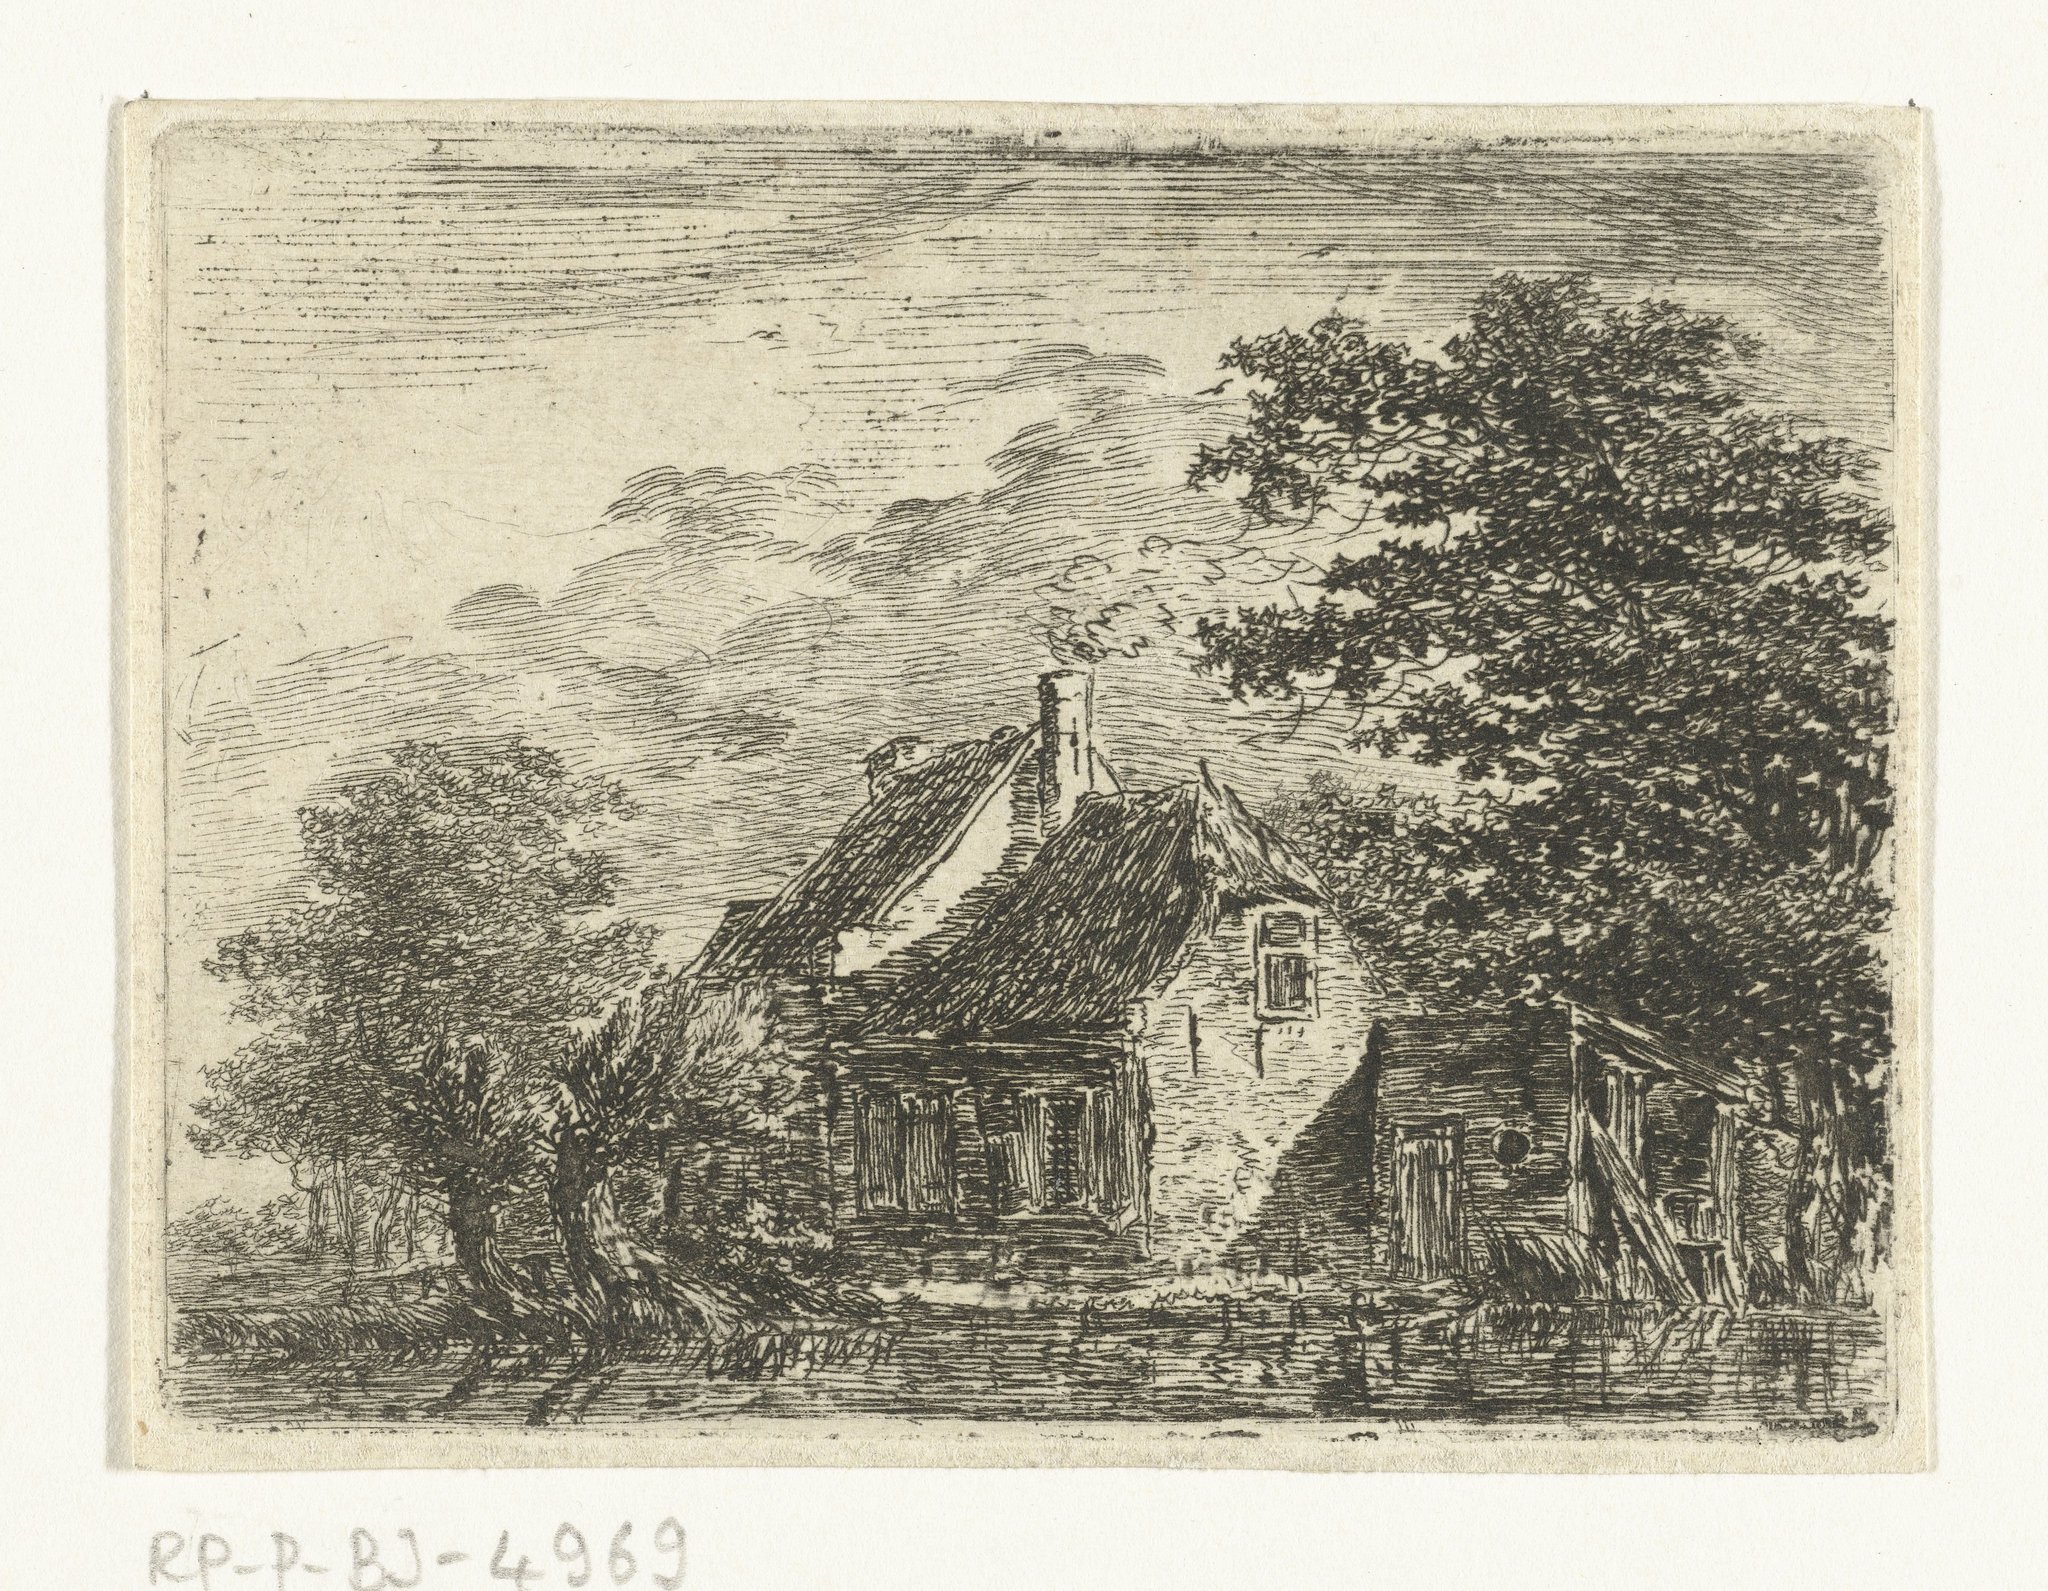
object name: print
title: Boerderij aan een vaart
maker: hermanus van brussel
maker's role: draughtsman, print maker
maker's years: 1763-1815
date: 1800-1815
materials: paper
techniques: drypoint, etching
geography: netherlands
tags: landscapes in the temperate zone, farm or solitary house in landscape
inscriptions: collector's mark: Lugt 2228